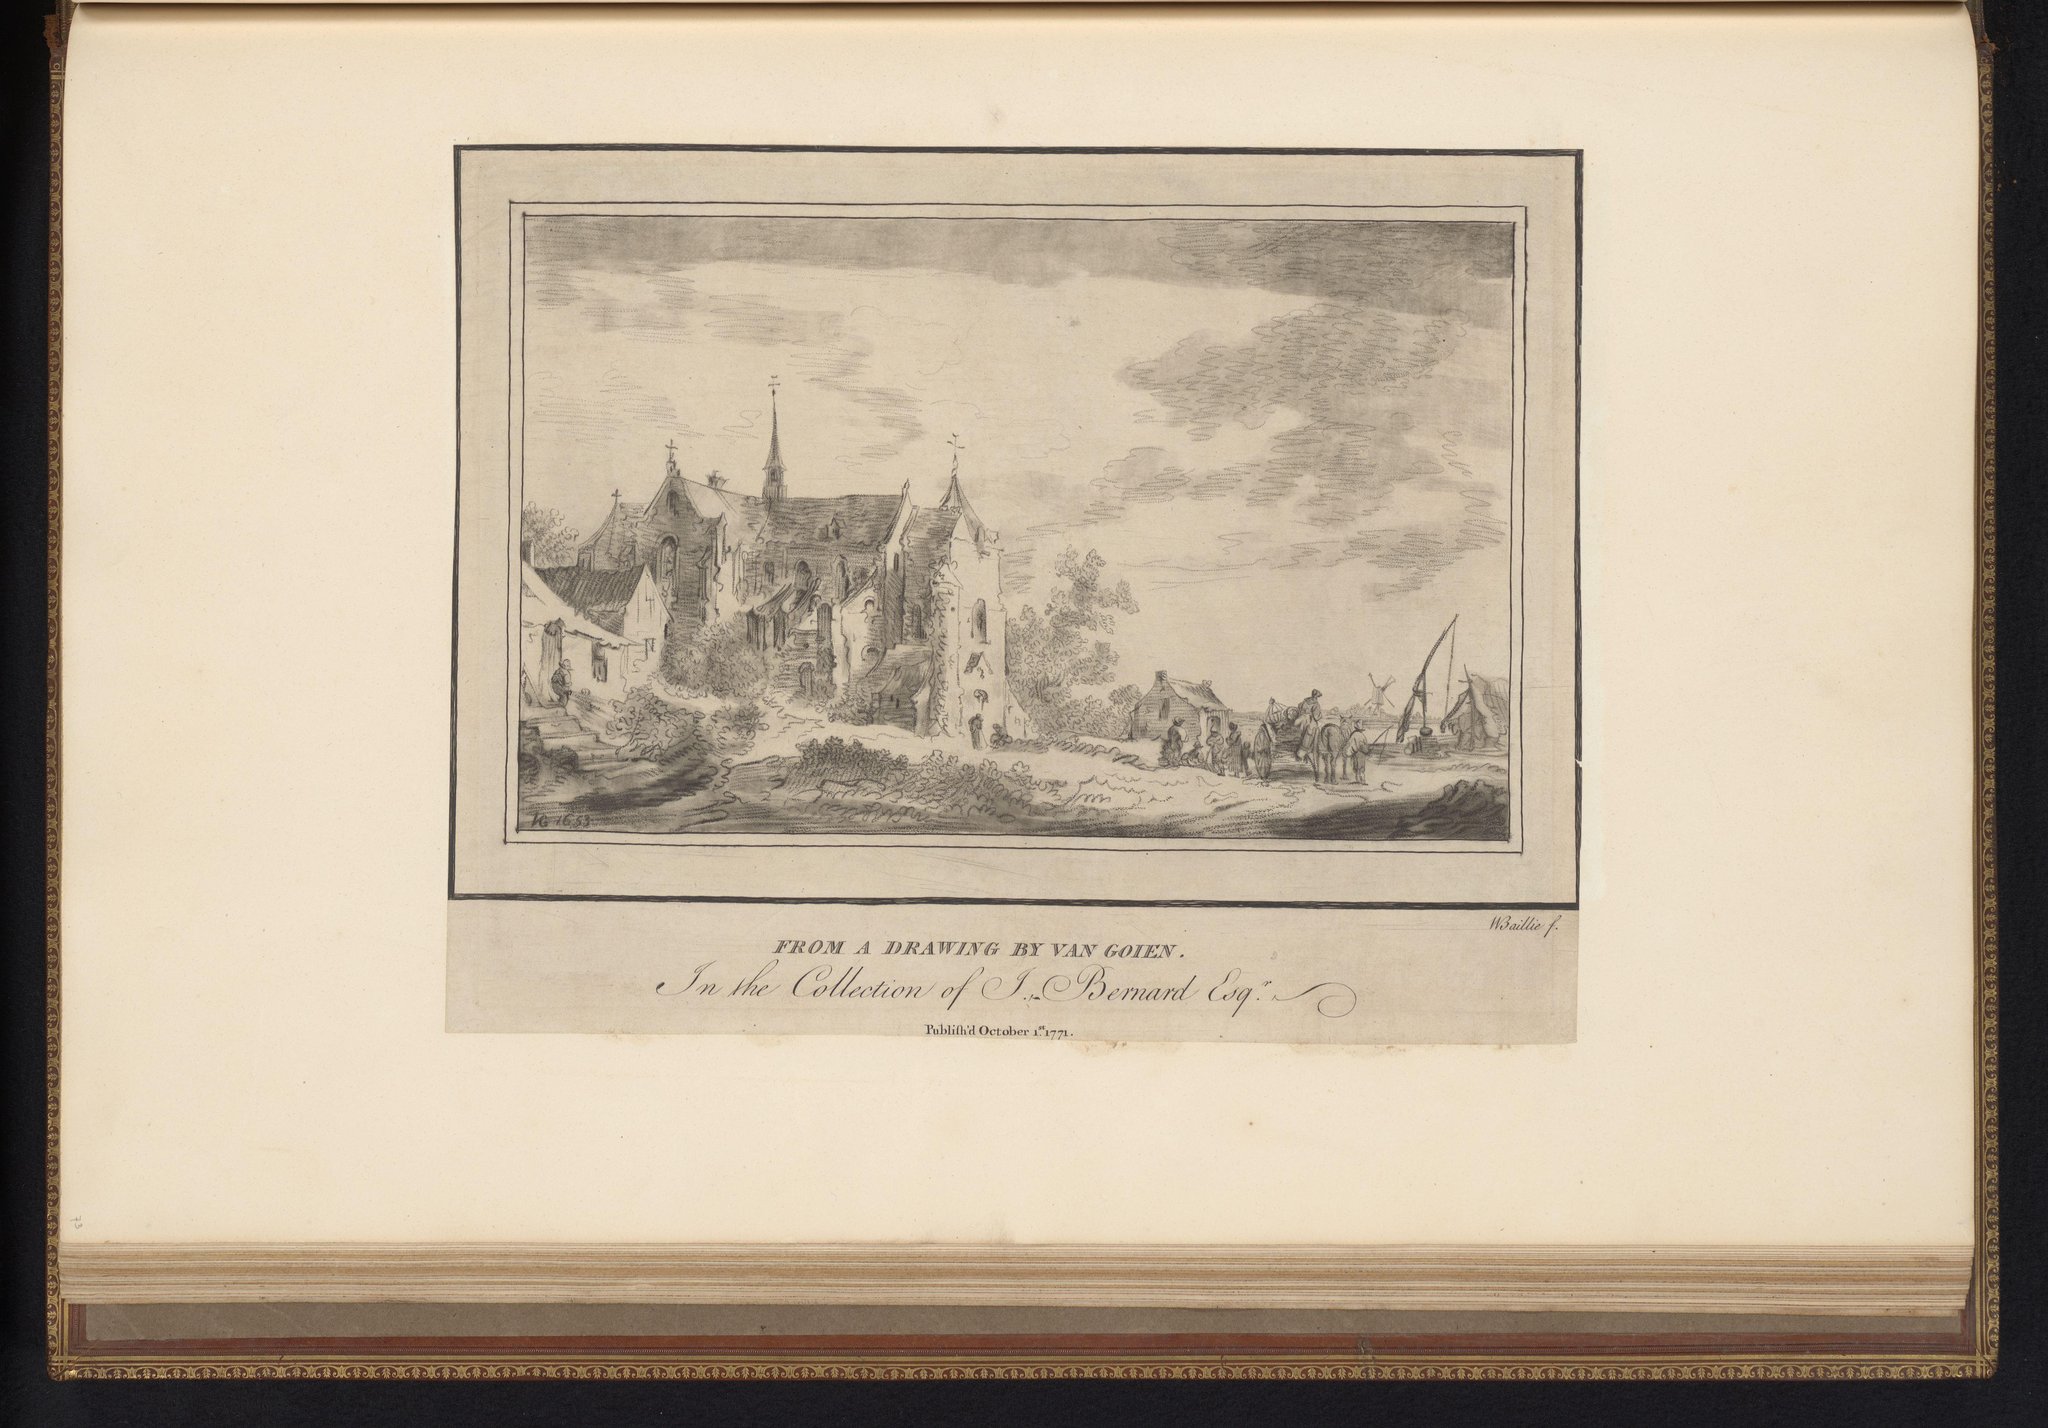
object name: print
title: Zeedorp met kerk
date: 1771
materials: paper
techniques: printmaking, intaglio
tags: landscapes, building of church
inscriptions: date